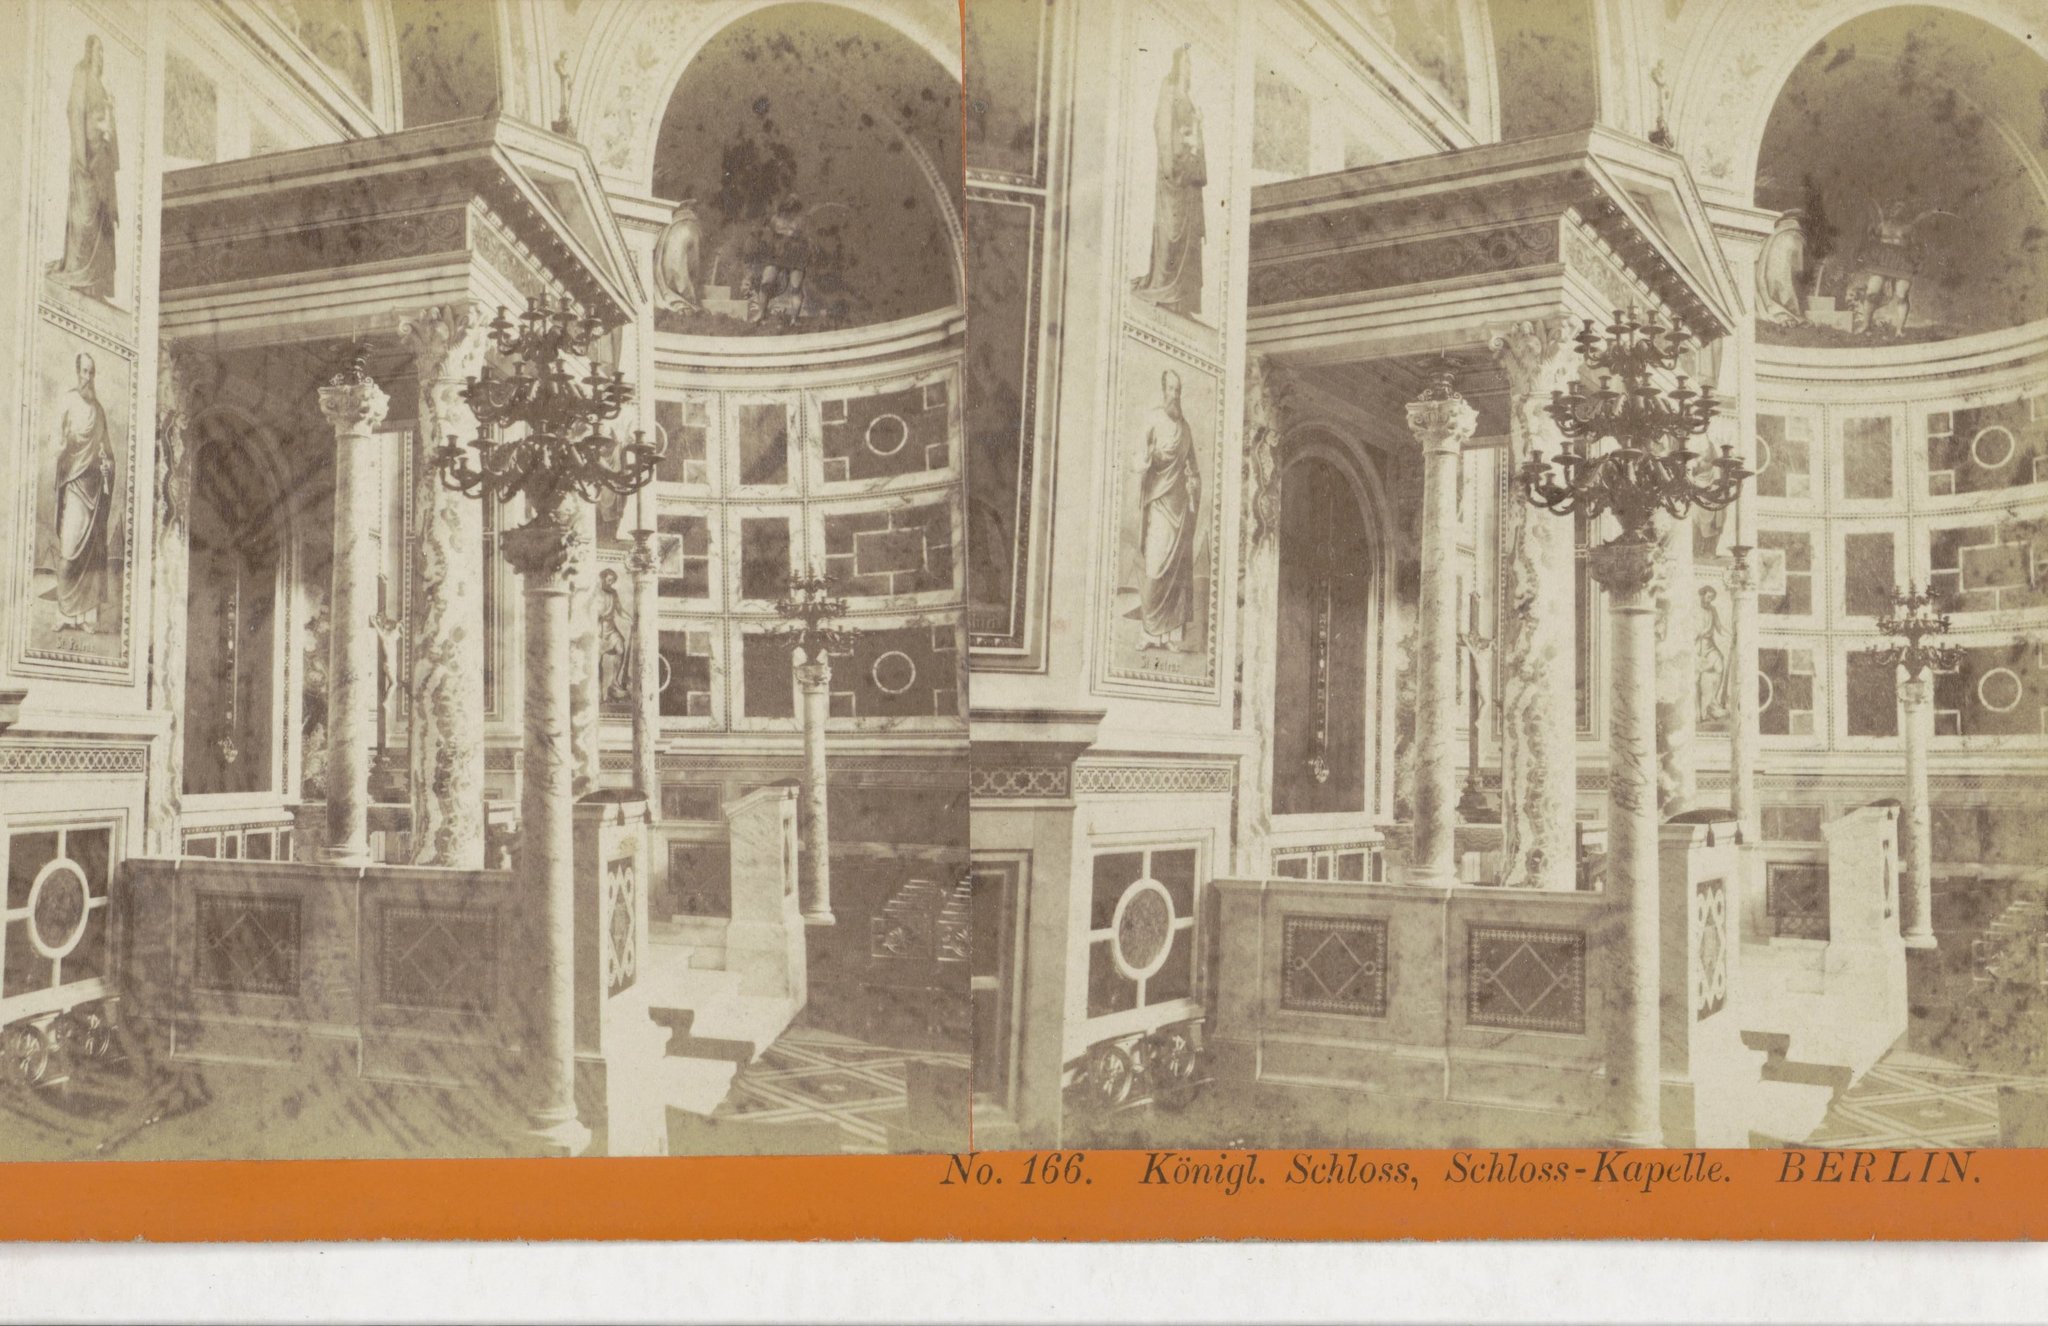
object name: stereograph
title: Kapel in het Berliner Stadtschloss, Berlijn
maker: johann friedrich stiehm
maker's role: fotograaf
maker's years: 1826-1902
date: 1868-1870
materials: cardboard, paper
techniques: albumen print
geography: berlin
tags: berliner stadtschloss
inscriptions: number: ‘No. 166.’